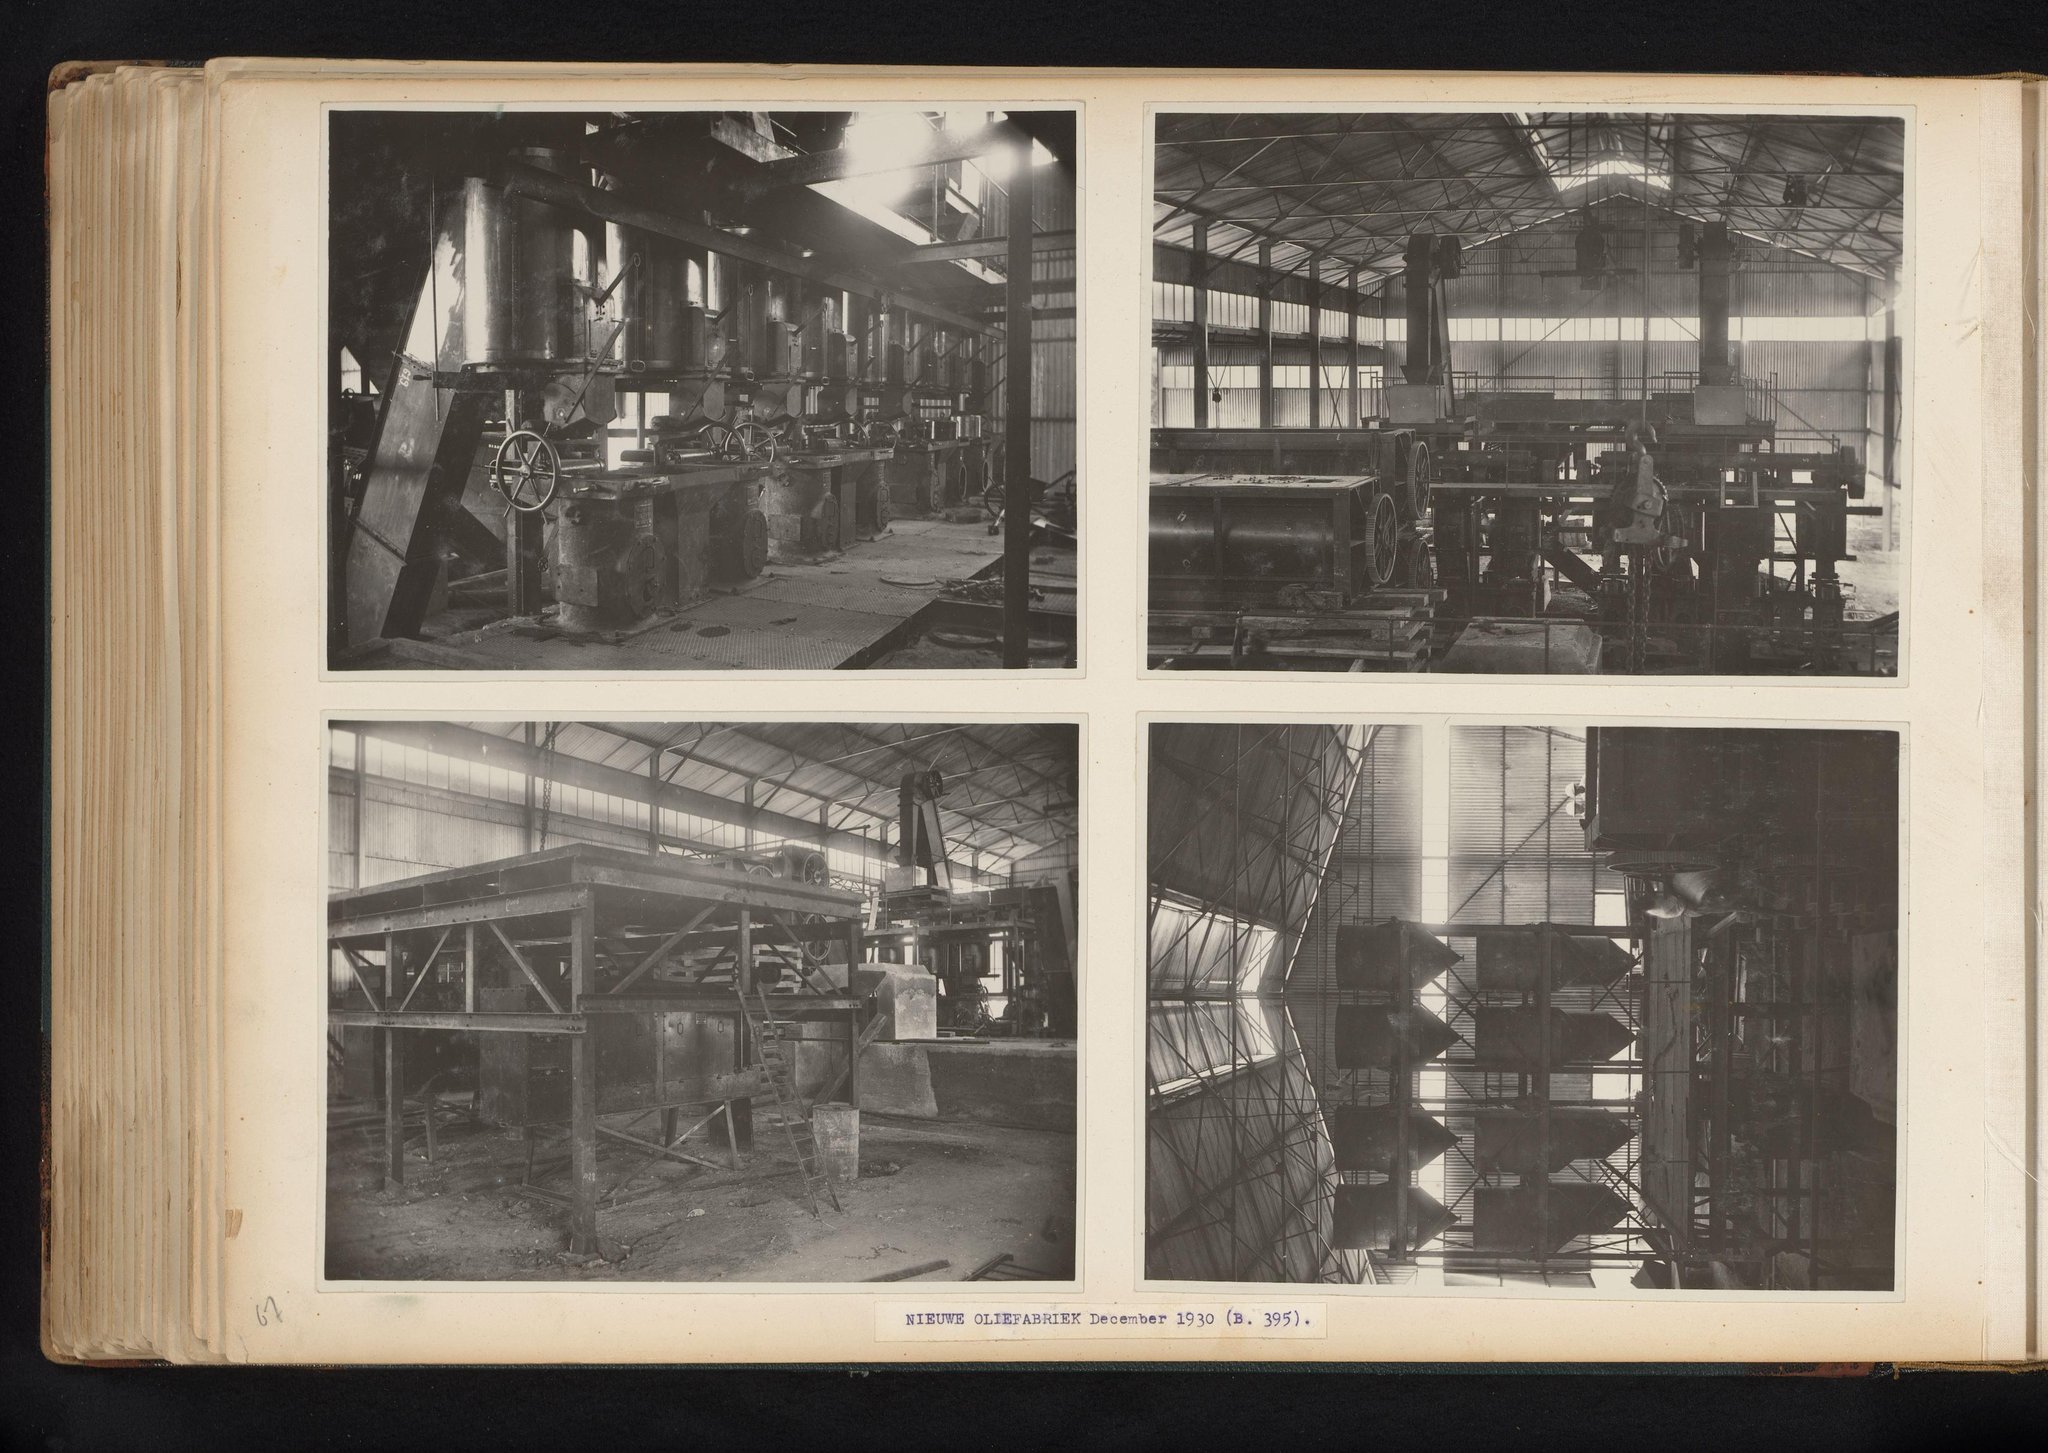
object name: album leaf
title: Nieuwe Oliefabriek December 1930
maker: Anonymous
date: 1912-1930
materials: cardboard, photographic support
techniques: gelatin silver print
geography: sumatra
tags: plantation, interior of industrial structures (regardless of the materials processed or the products made, (non-fruit) products of plants or trees: palm oil, sumatra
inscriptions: inscription: ‘Nieuwe Oliefabriek December 1930 (B. 395)’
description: Blad met vier foto's van de nieuwe palmoliefabriek, waarschijnlijk te Pernantian, december 1930. Onderaan het blad een etiket met onderschrift. Onderdeel van het fotoalbum over de plantages Brussel en Pernantian van de Sumatra Caoutchouc Maatschappij op de Oostkust van Sumatra in de jaren 1910-1935.